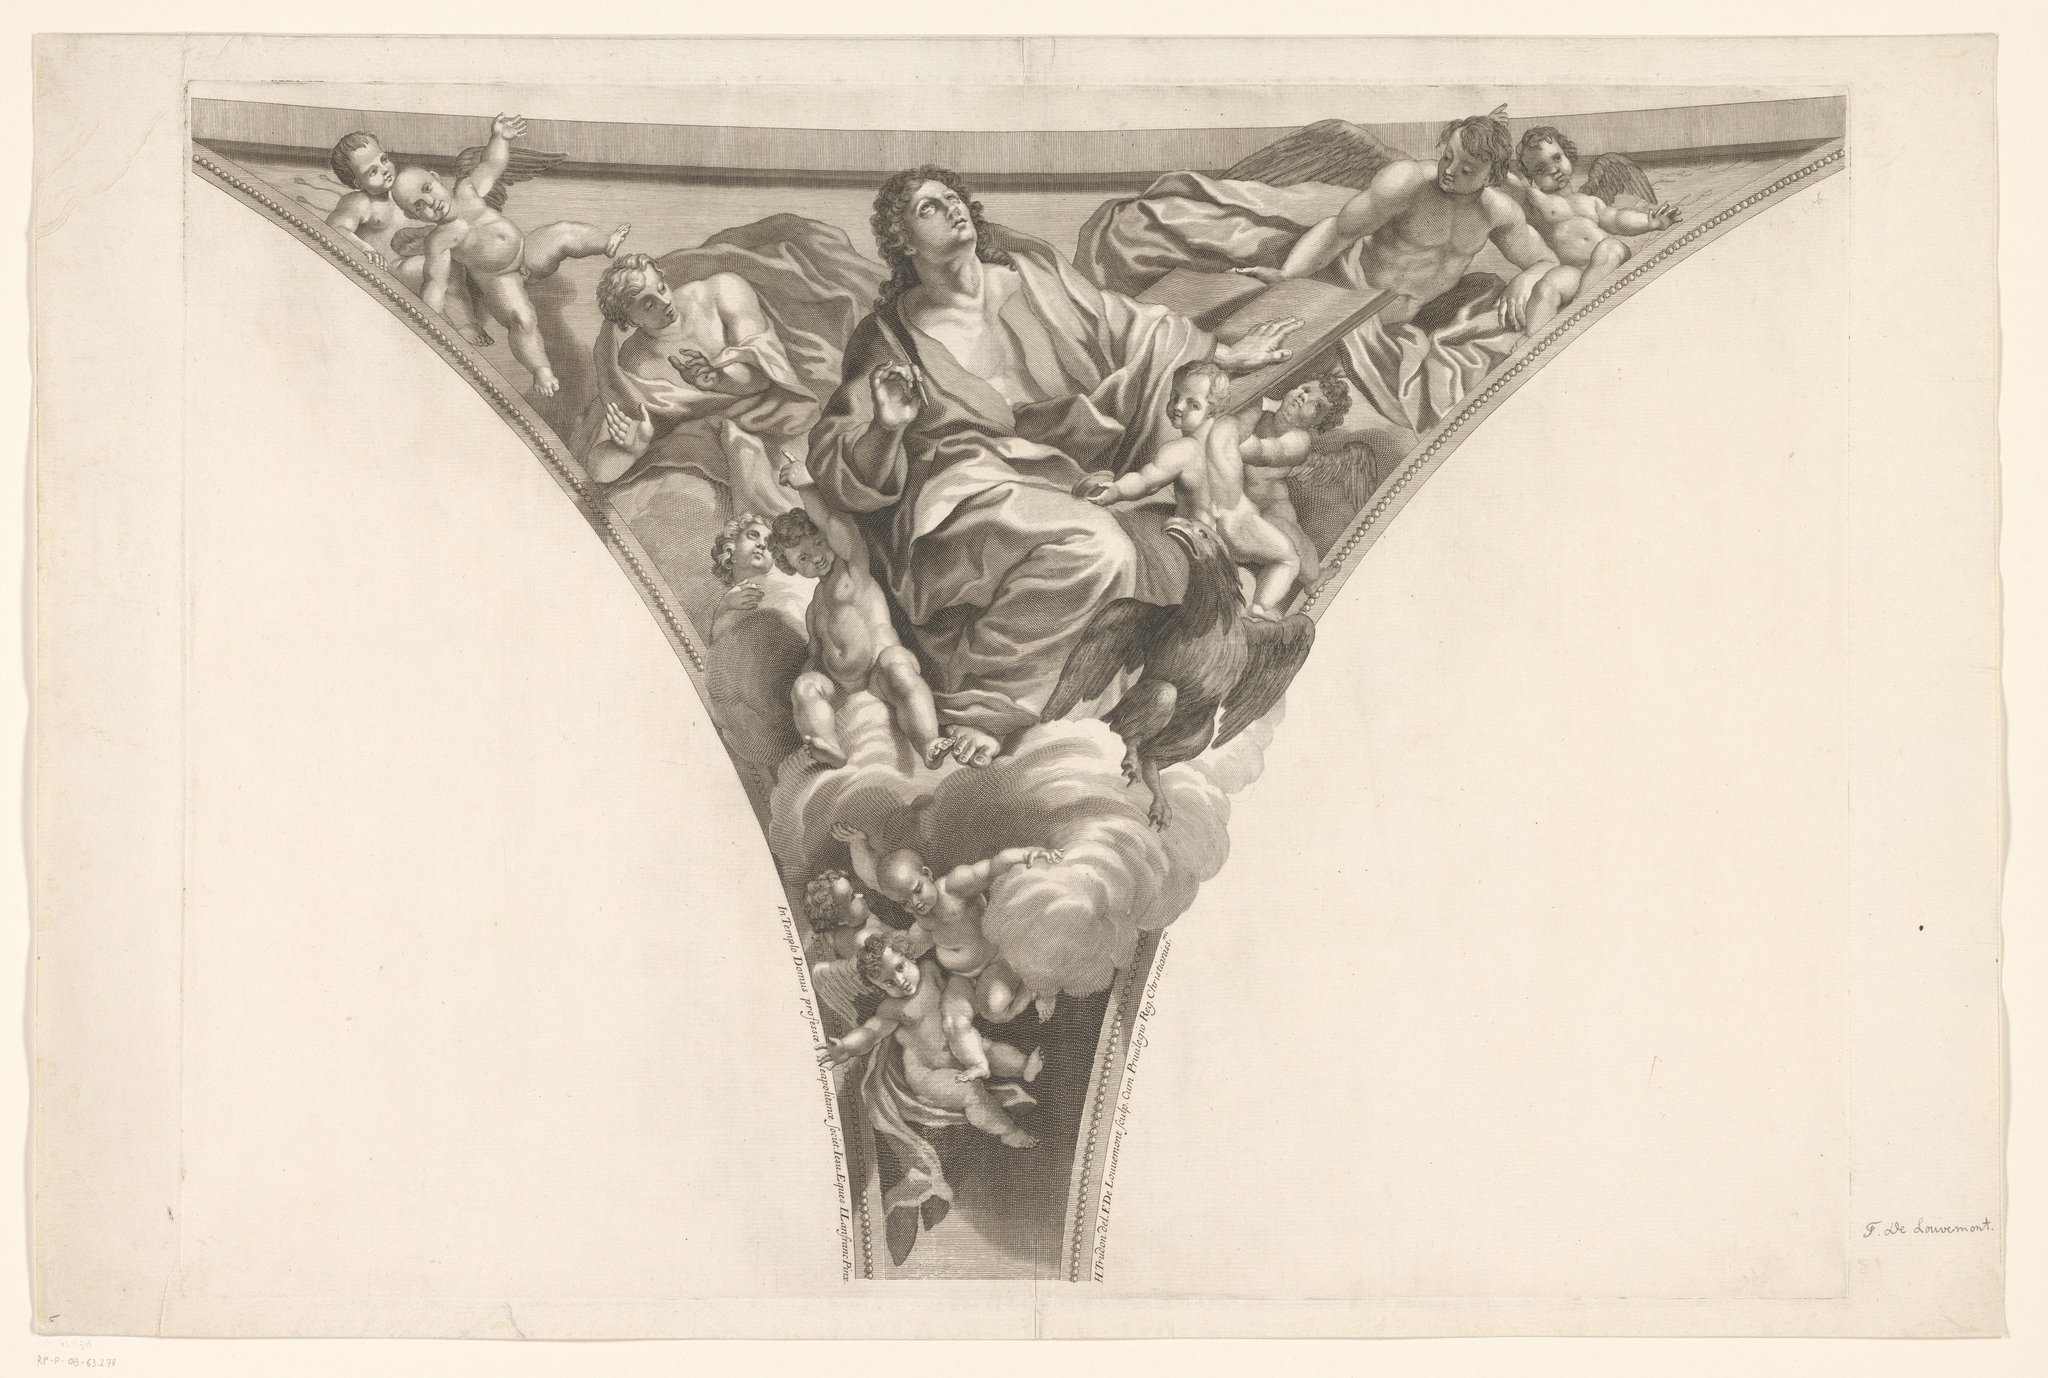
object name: print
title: H. Johannes omgeven door adelaar en engelen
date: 1658-1748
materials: paper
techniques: engraving, etching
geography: france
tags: the apostle john the evangelist; possible attributes: book, cauldron, chalice with snake, eagle, palm, scroll, eagle (possibly with book) ~ symbol of st. john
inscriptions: collector's mark: Lugt 240, watermark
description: Johannes de Evangelist zittend op een wolk, schrijvend in een boek, omgeven door engelen. Naast hem zijn attribuut de adelaar.